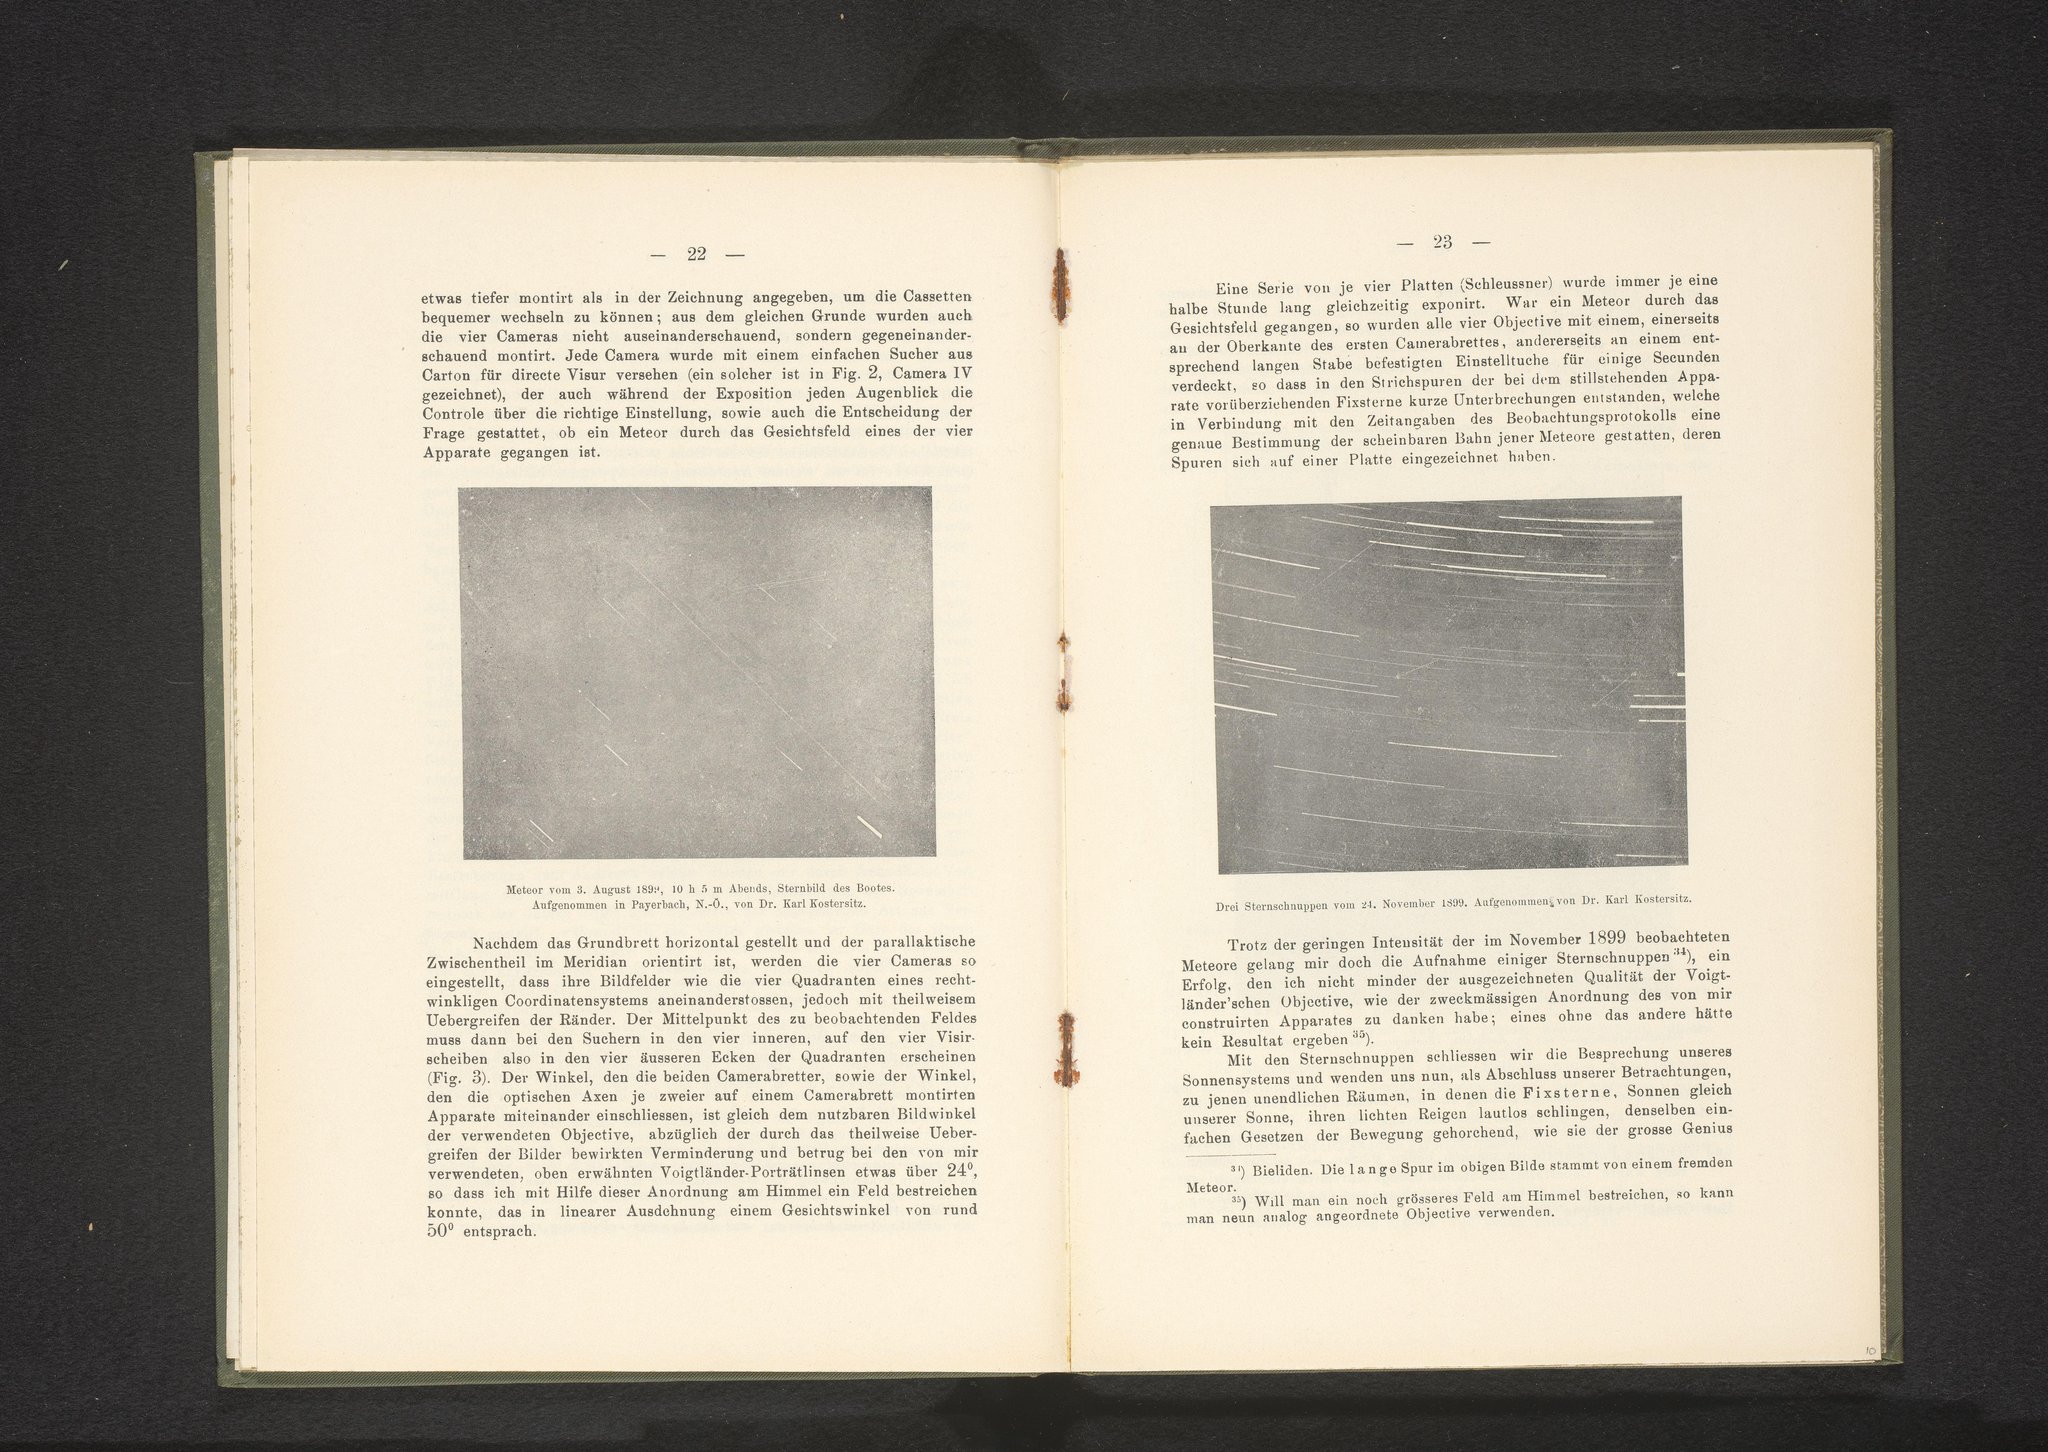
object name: page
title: Vallende sterren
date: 1899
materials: paper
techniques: autotype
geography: payerbach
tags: meteor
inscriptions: inscription: ‘Sternbild des Bootes. Aufgenommen in Payerbach, N-Ö.’